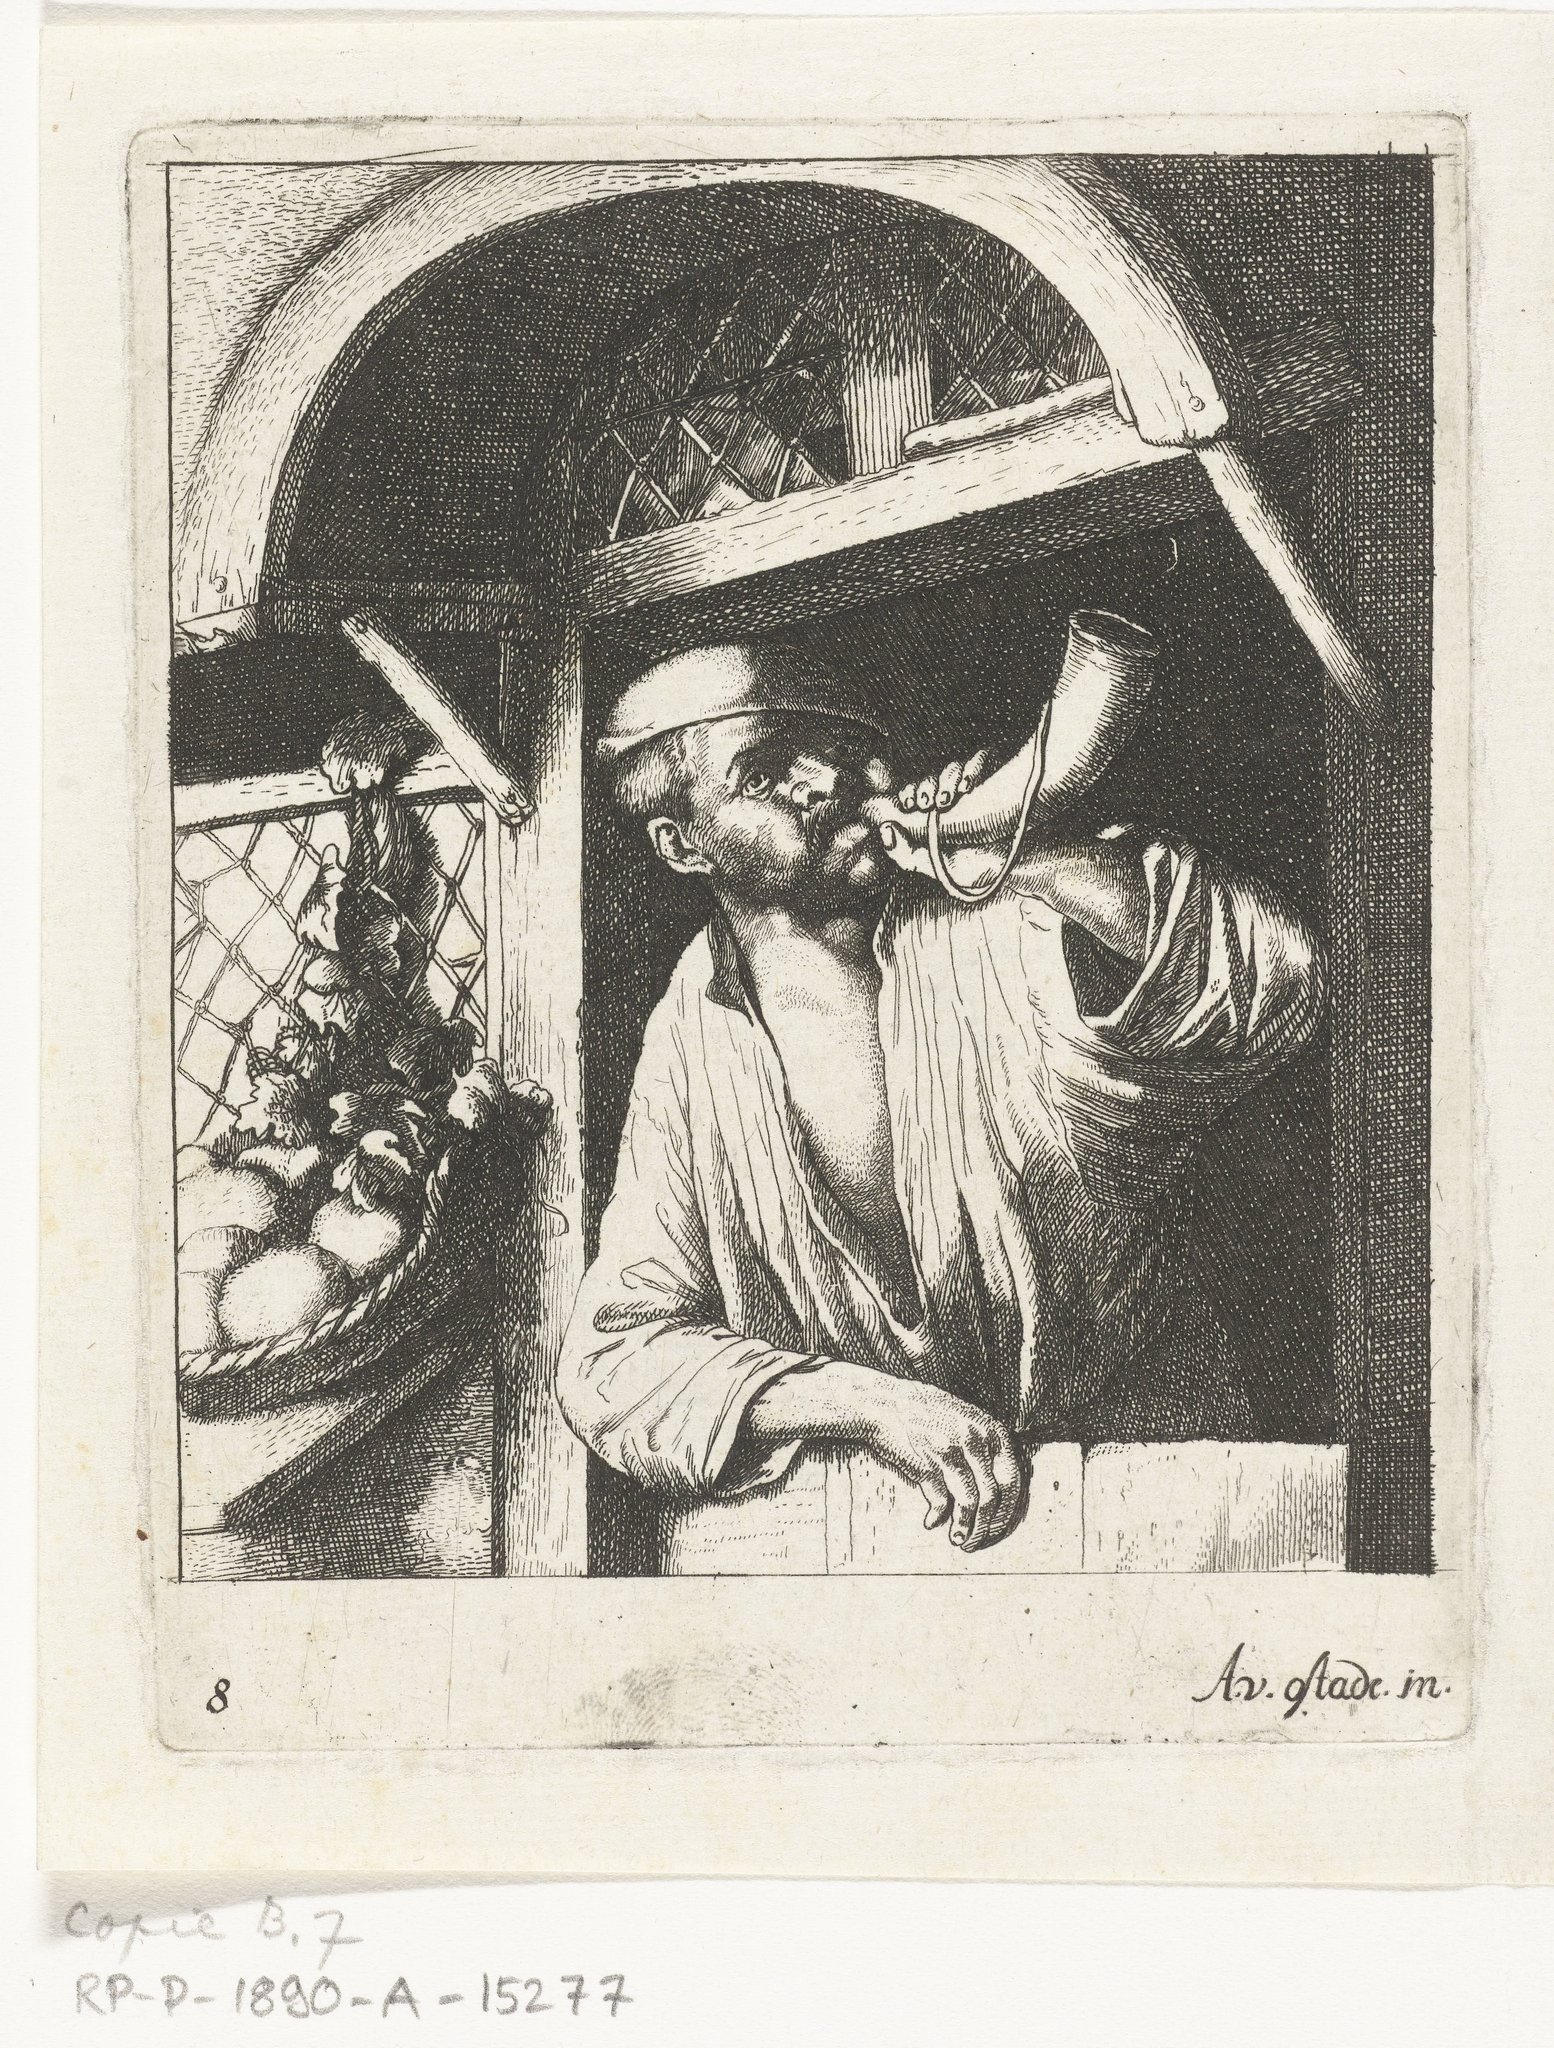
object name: print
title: Caprice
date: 1655-1690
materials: paper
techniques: etching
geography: amsterdam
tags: hornblowing baker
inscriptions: collector's mark: Lugt 2228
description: Bakker blaast op een hoorn terwijl hij in de deuropening staat. Prent uit een serie van acht prenten naar voorstellingen van A. van Ostade.